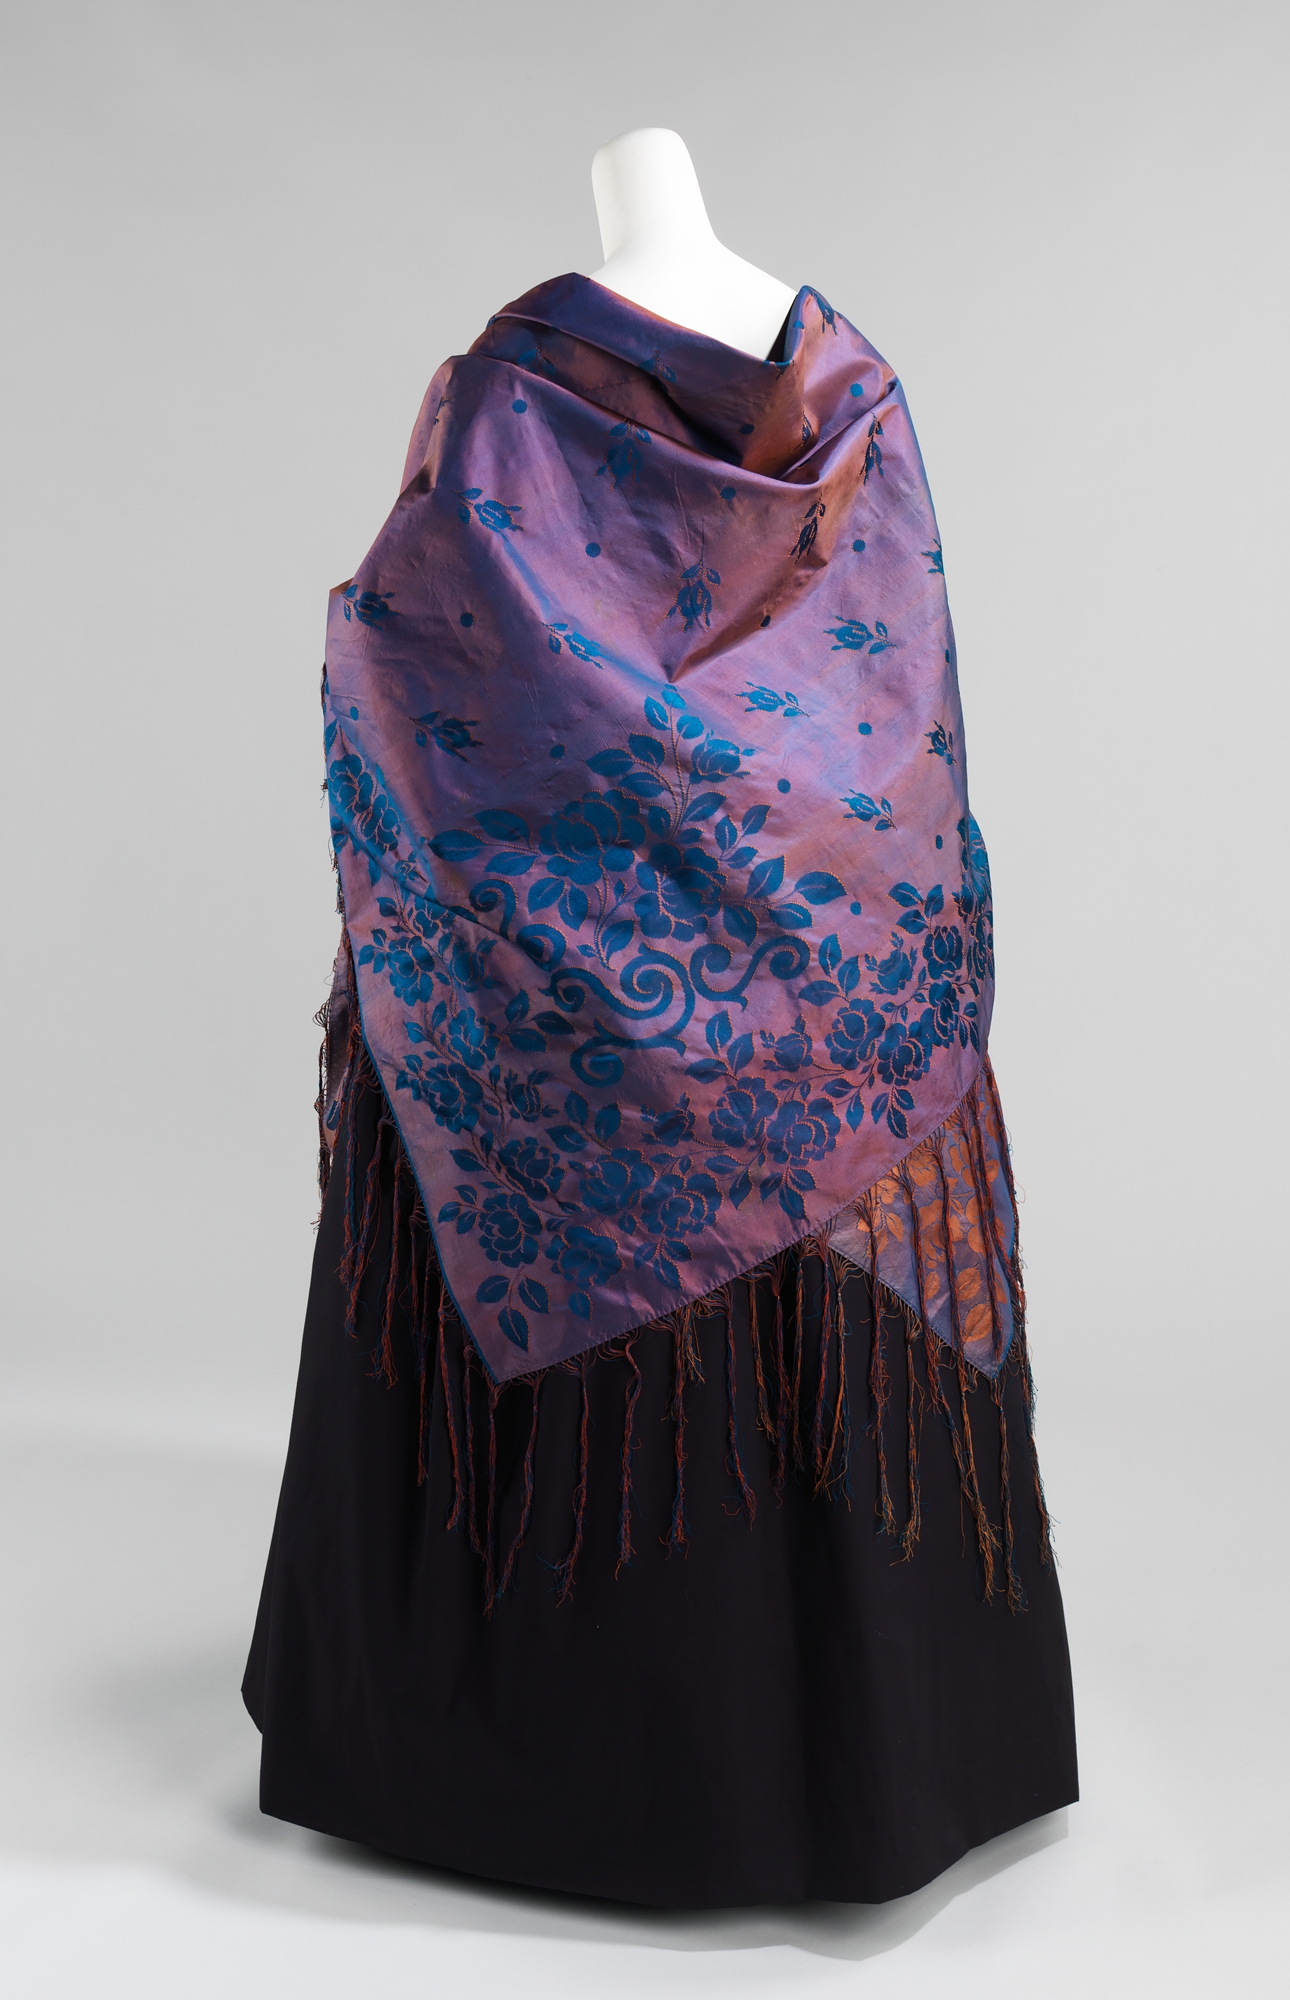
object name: shawl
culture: american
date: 1840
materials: silk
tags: flowers